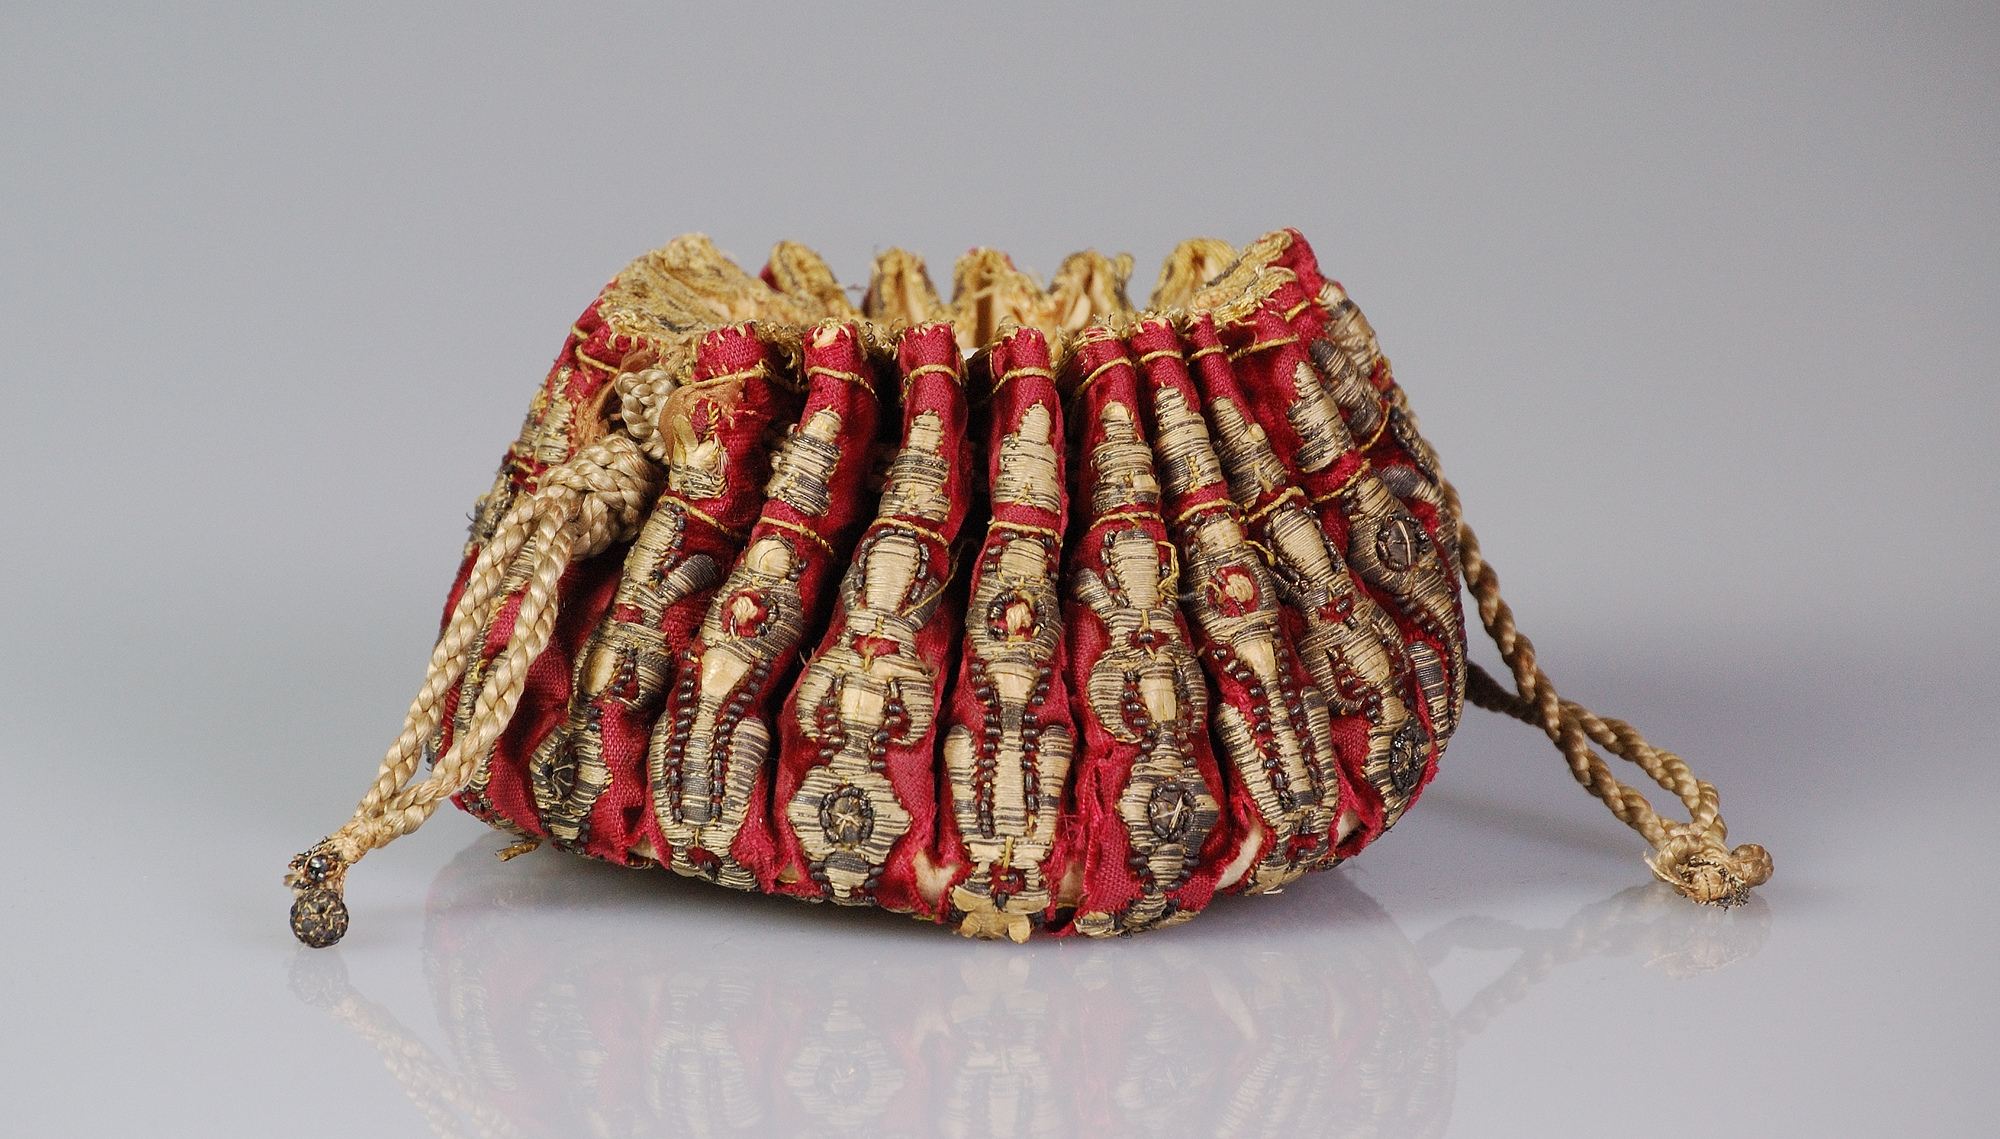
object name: gaming purse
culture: french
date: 1667-1700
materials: leather, silk